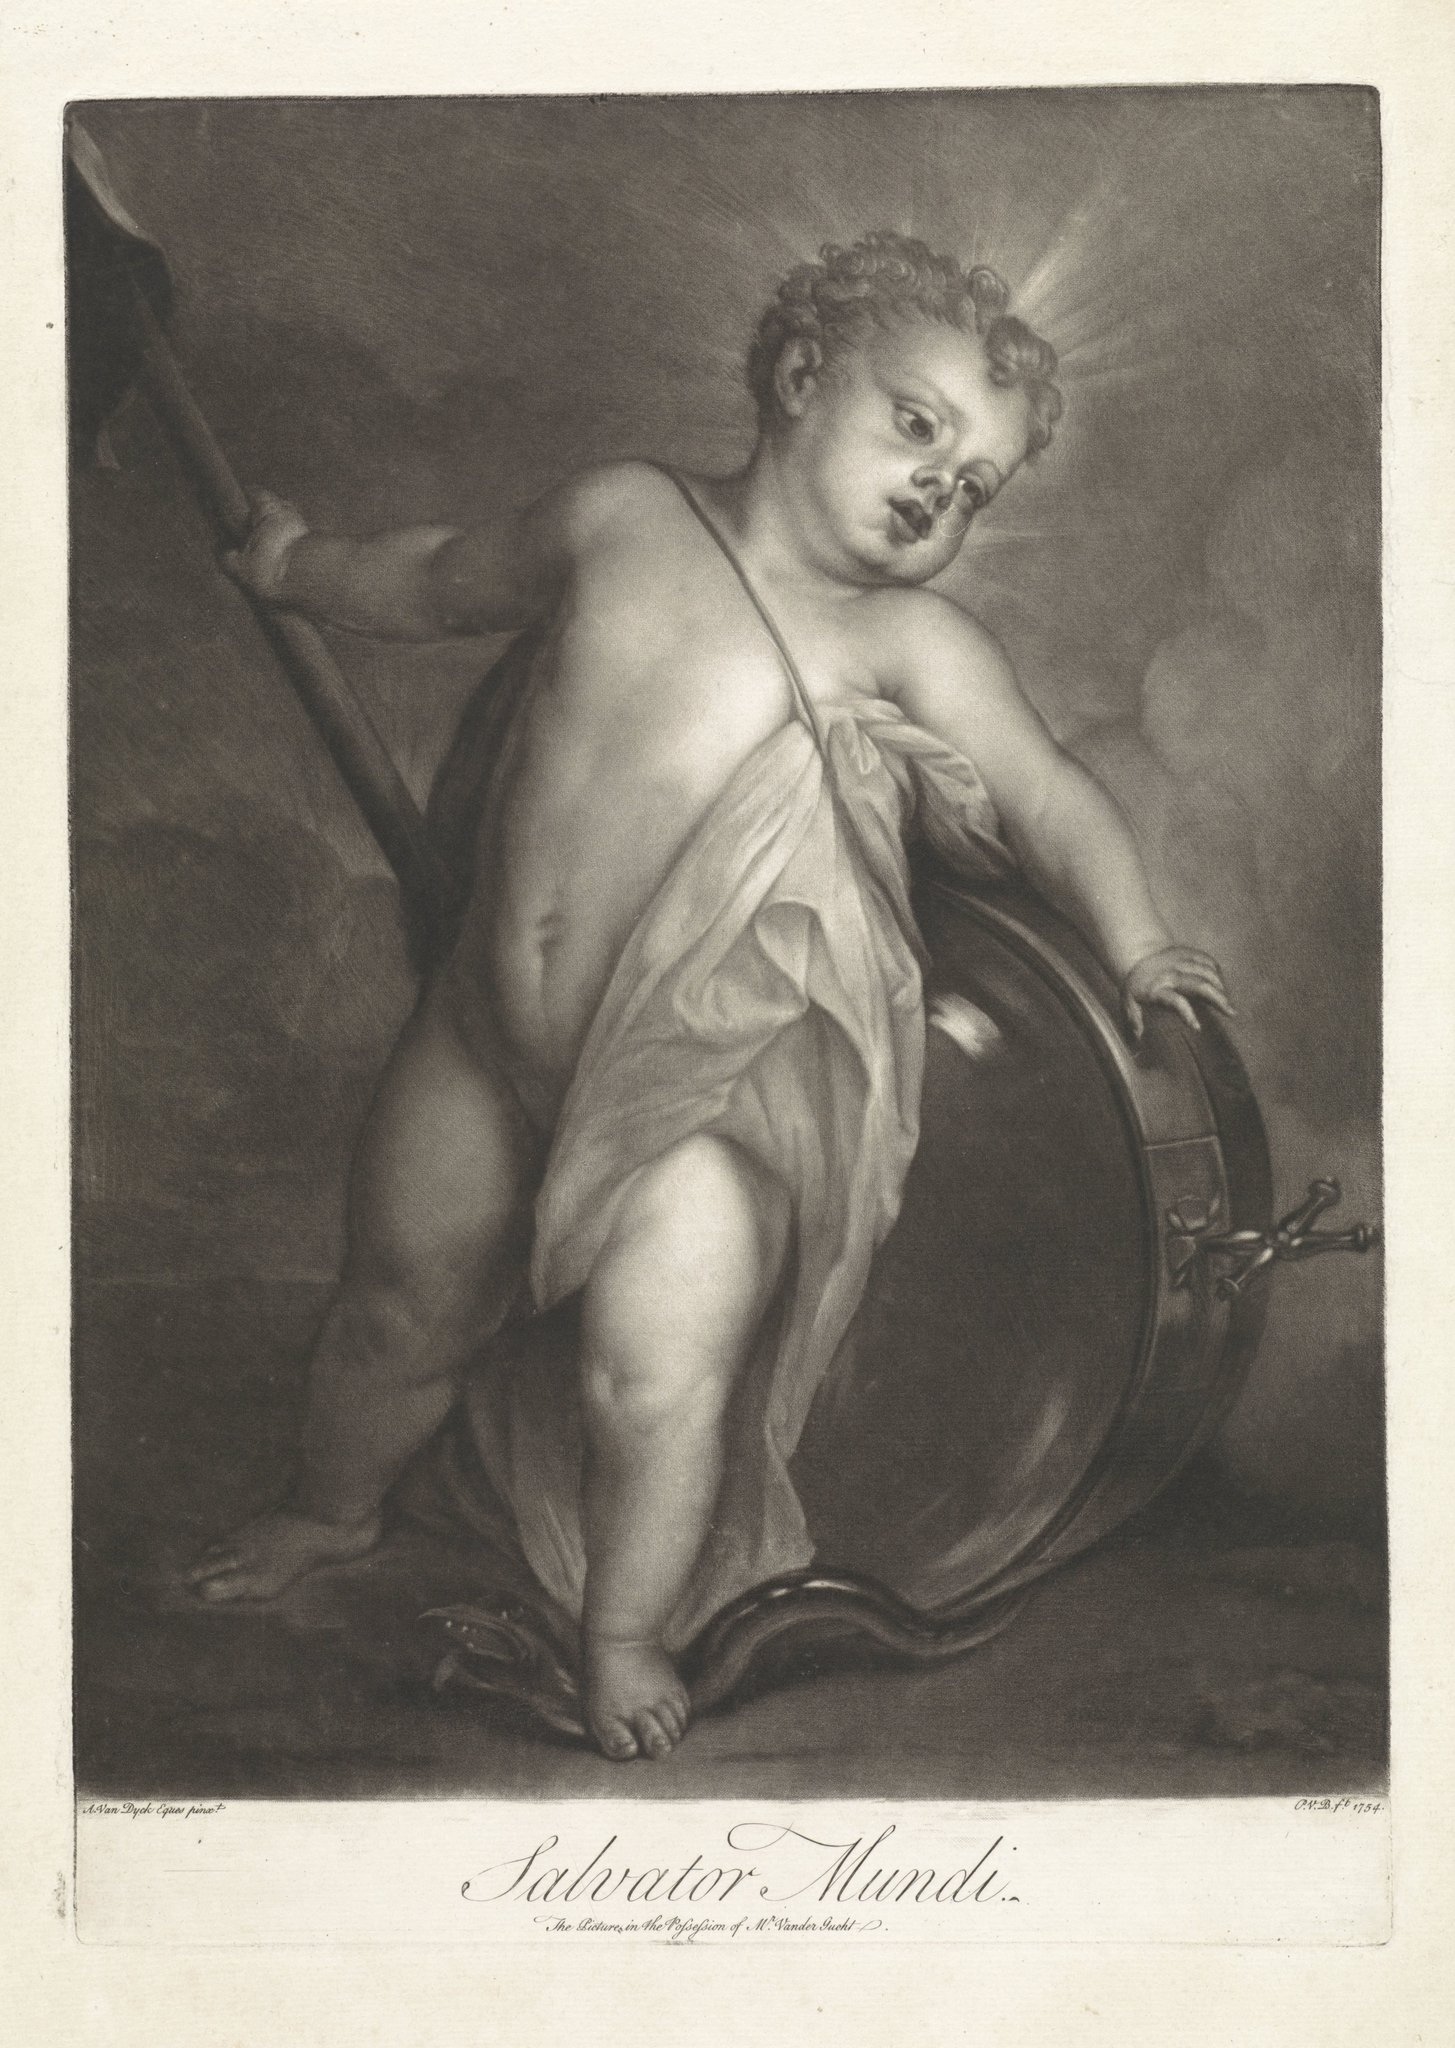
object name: print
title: Christuskind als Salvator Mundi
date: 1754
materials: paper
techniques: engraving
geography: england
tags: 'salvator mundi', making a blessing gesture; an orb in his hand or at his feet, christ-child ~ types of adult christ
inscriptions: collector's mark: Lugt 240